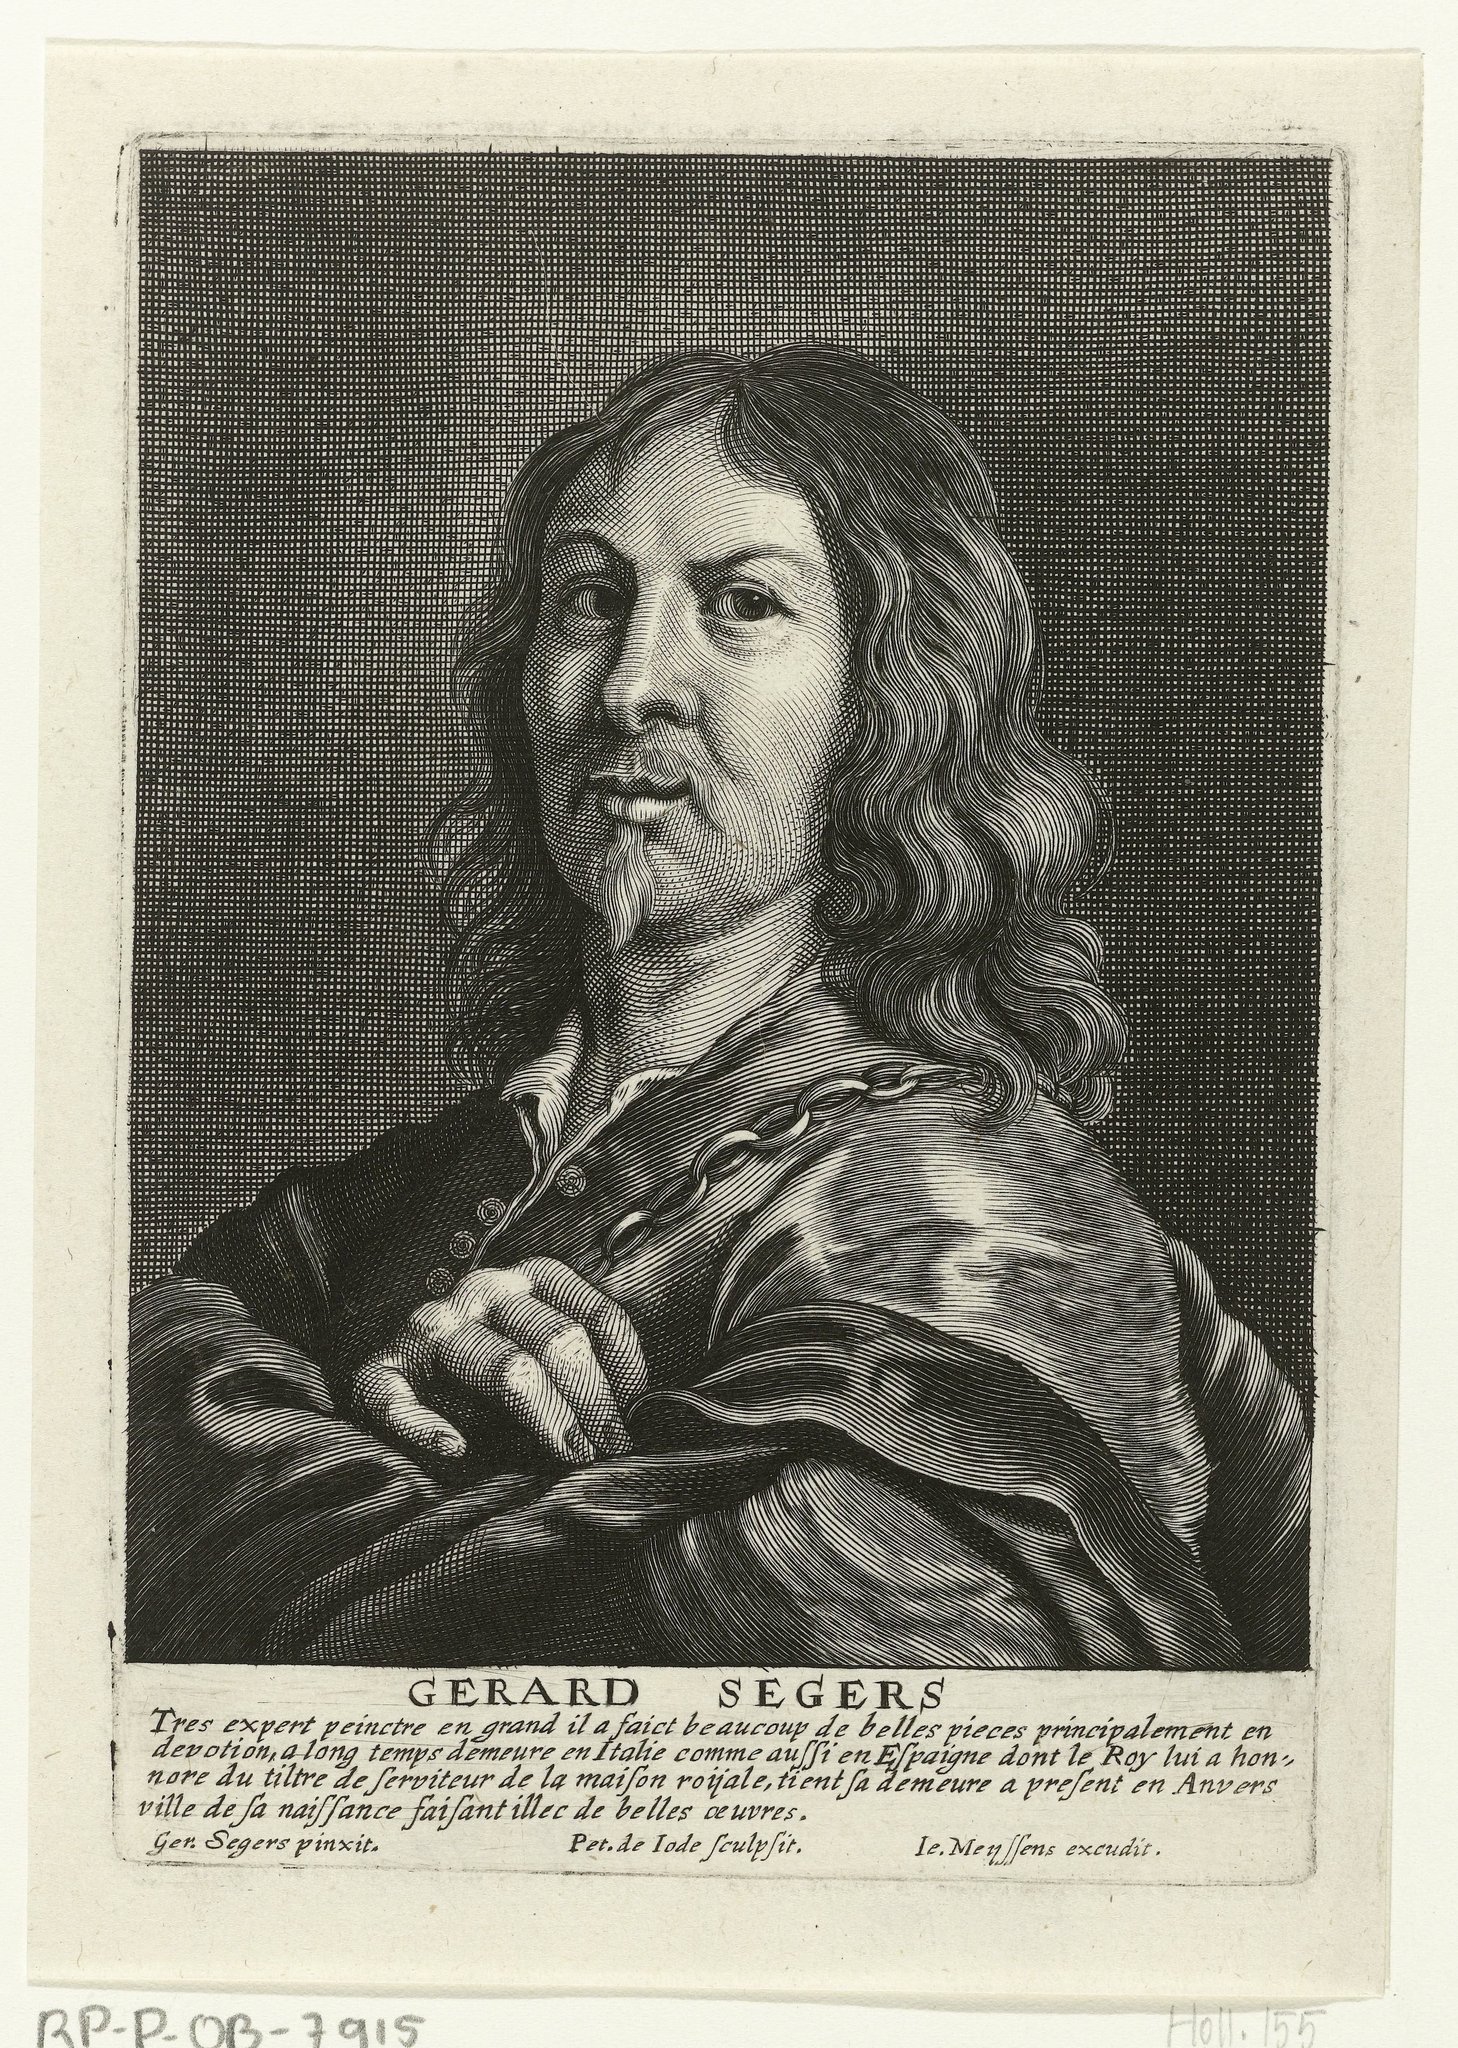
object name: print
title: Portret van Gerard Seghers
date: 1628-1670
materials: paper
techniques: engraving, etching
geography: antwerp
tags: antwerp, painter, print maker, gerard seghers, necklace (+ men's clothes)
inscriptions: collector's mark: Lugt 2228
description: Busteportret van Gerard Seghers. Hij draagt een keten om zijn hals en heeft zijn armen over elkaar geslagen. In de marge de naam van de geportretteerde en een vierregelig onderschrift in het Frans.